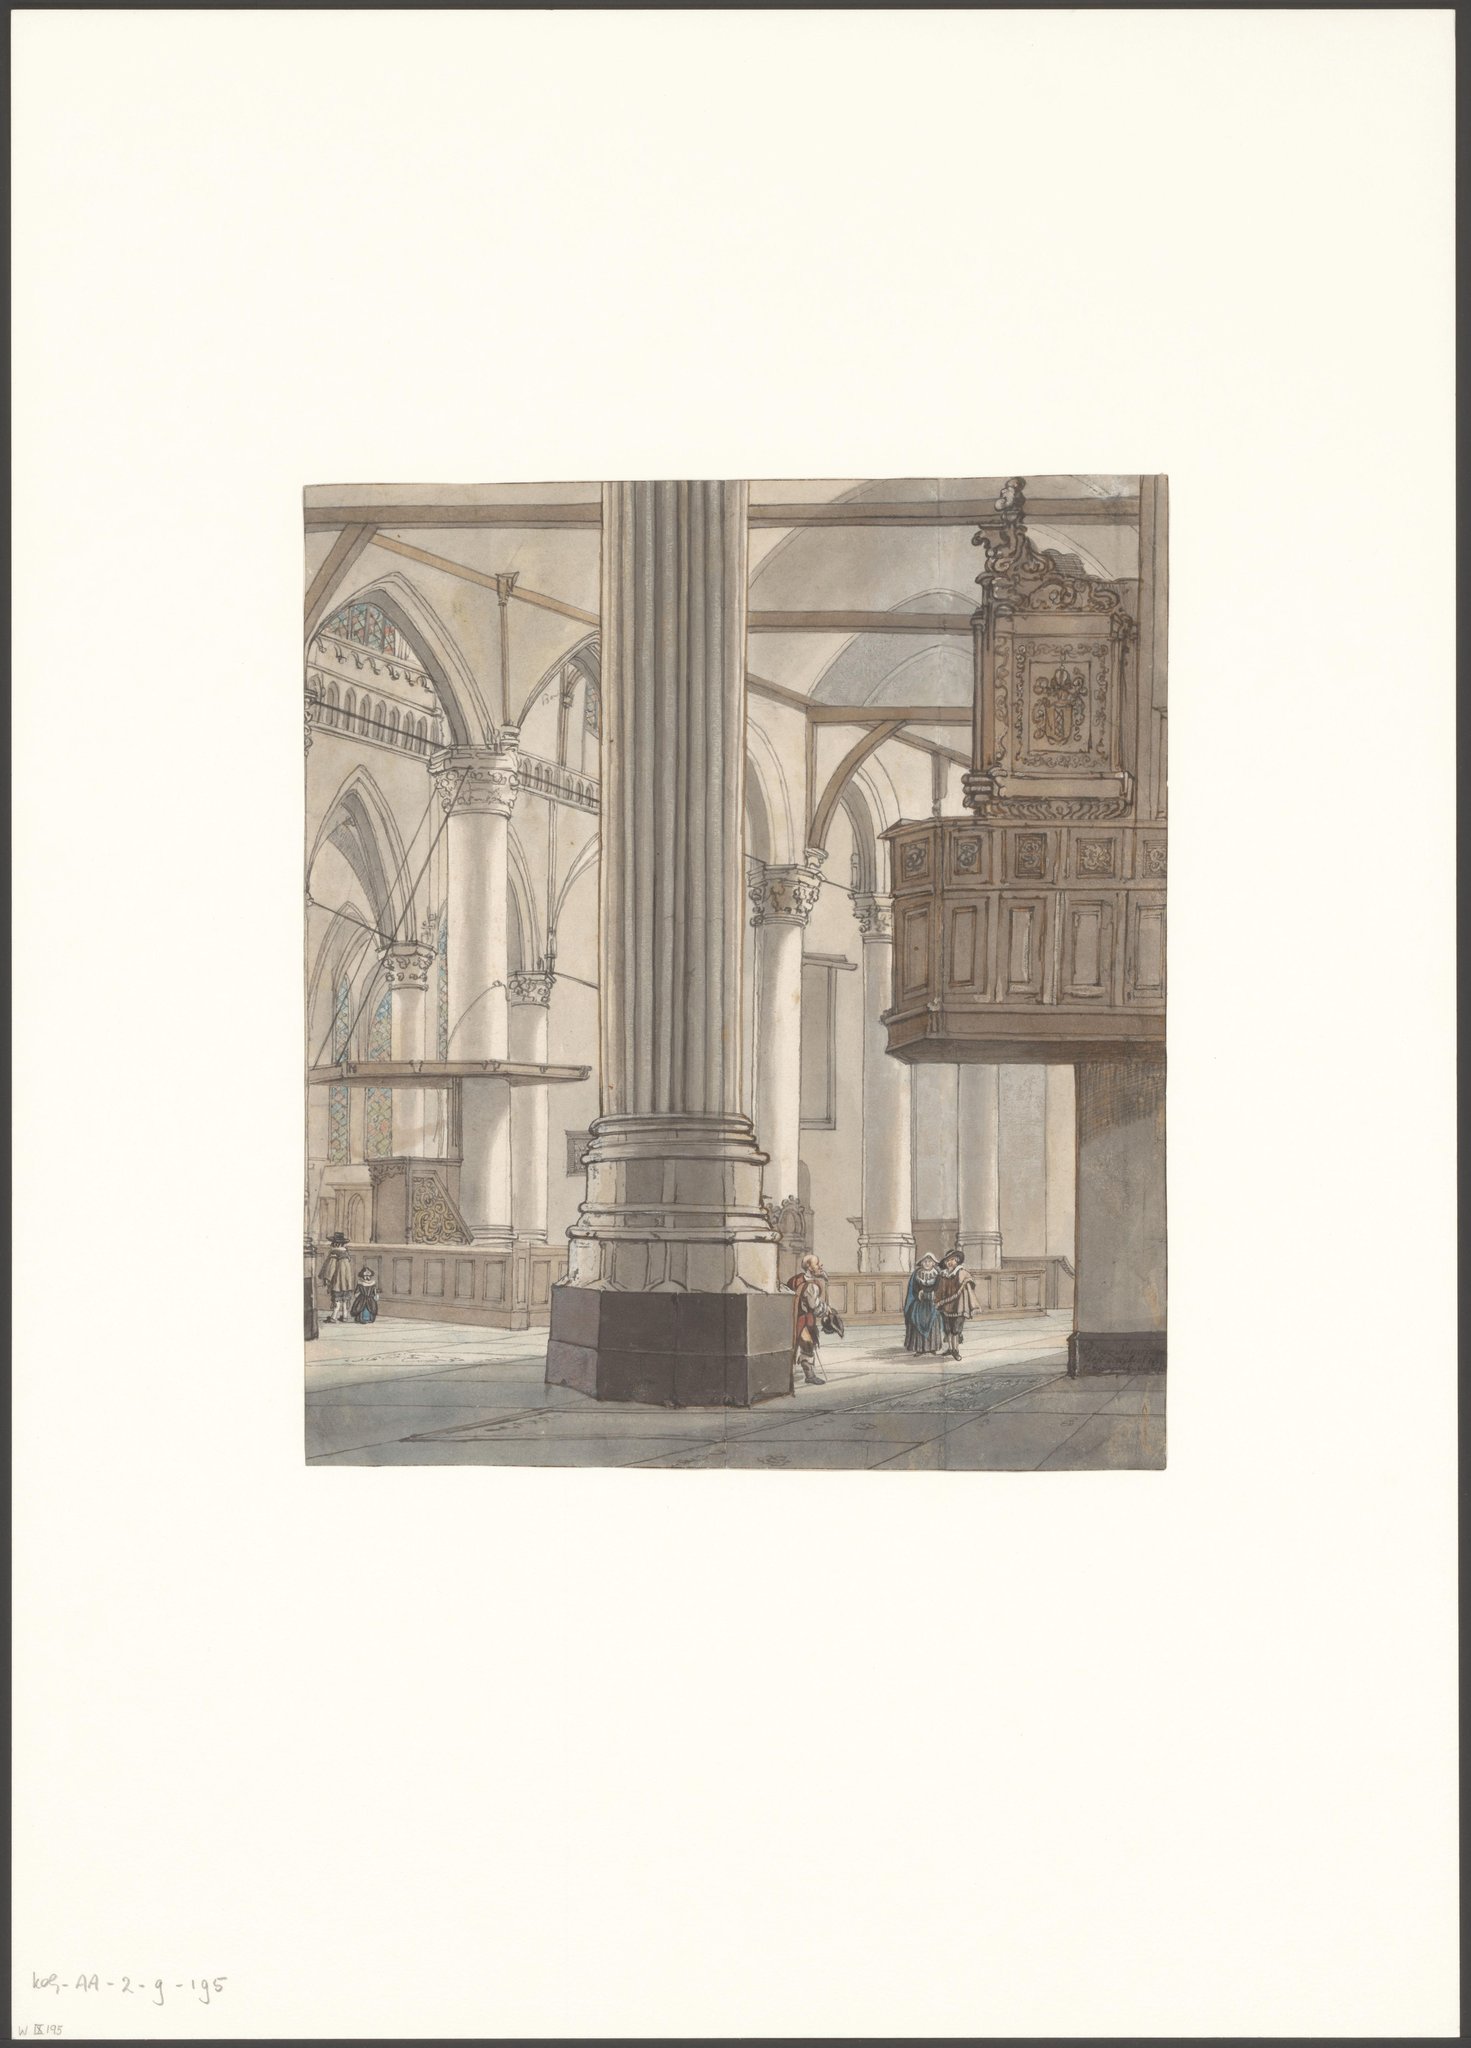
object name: drawing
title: Interieur van de Oude Kerk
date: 1736-1798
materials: paint, ink, paper, pencil, watercolor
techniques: brush, pen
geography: amsterdam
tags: parts of church interior: transept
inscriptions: inscription: ‘Pieter Saenredam / dese geteijkend 16[...] / St Nico. kerk in Amsterd.’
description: Tekening binnen de Atlas Van Eck ingedeeld op wijknummer 9.